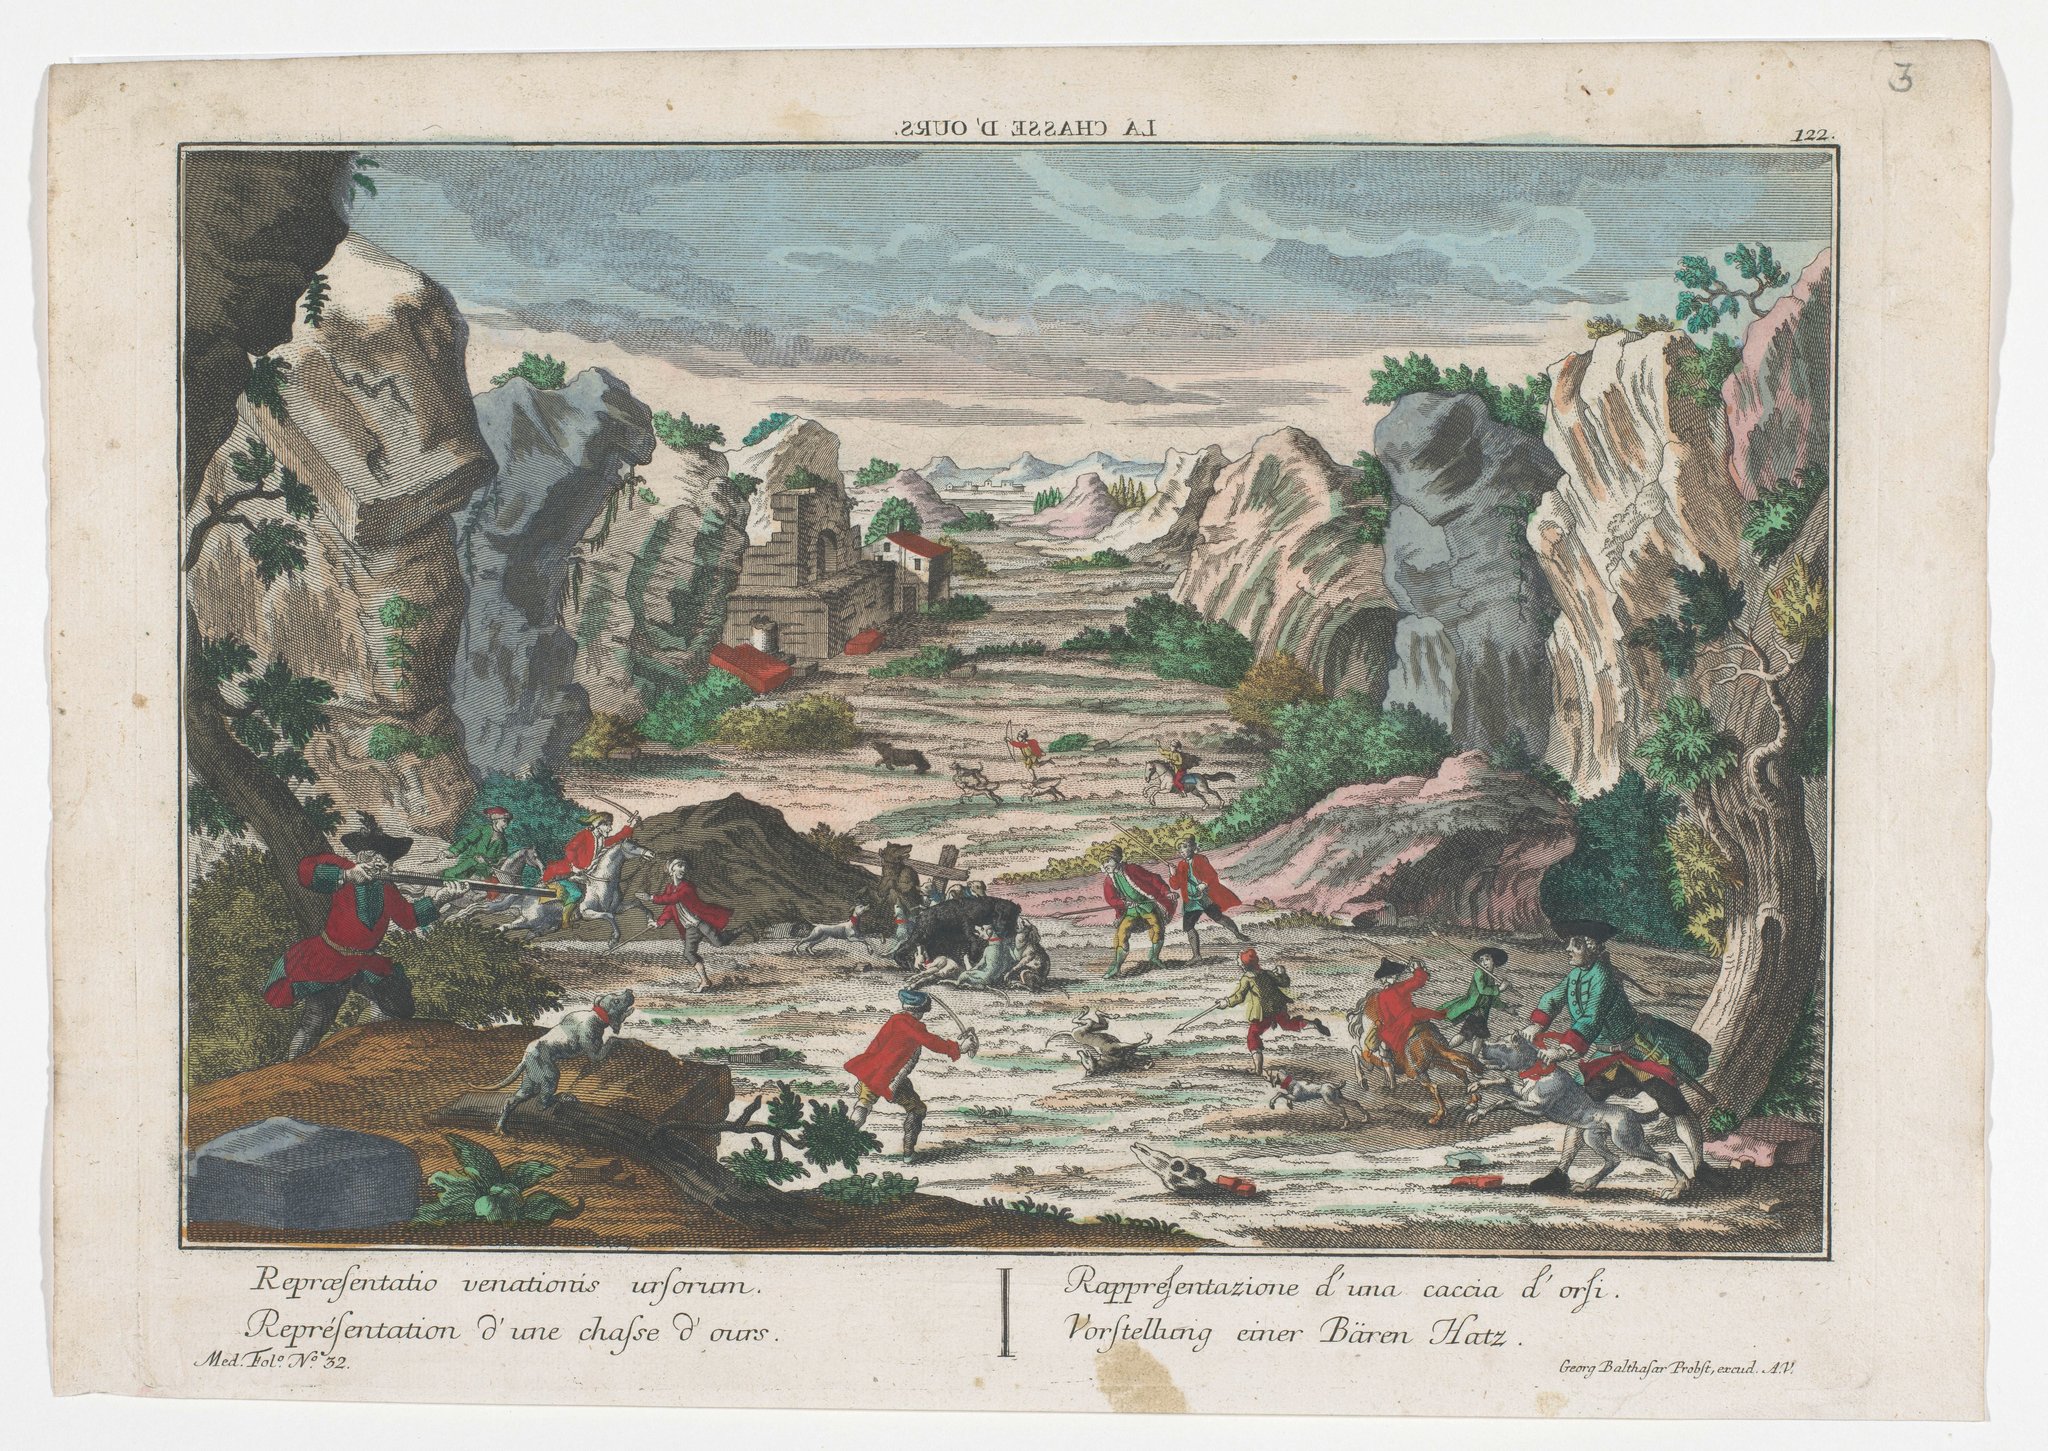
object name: print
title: Gezicht op een berenjacht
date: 1742-1801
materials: paper, watercolor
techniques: brush, etching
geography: augsburg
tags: hunting dogs, hunt ~ predatory animals (fox, lion), hunters hunting (n.b.: in 1988-1990 this notation denoted the concept of 43c11421 'hunters resting during the hunt'), beasts of prey, predatory animals: bear, horse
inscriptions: midden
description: De serie “Jachttaferelen”, met het nummer 32, bevat vier prenten met de nummers 119-122, waarvan dit nummer 122 is.